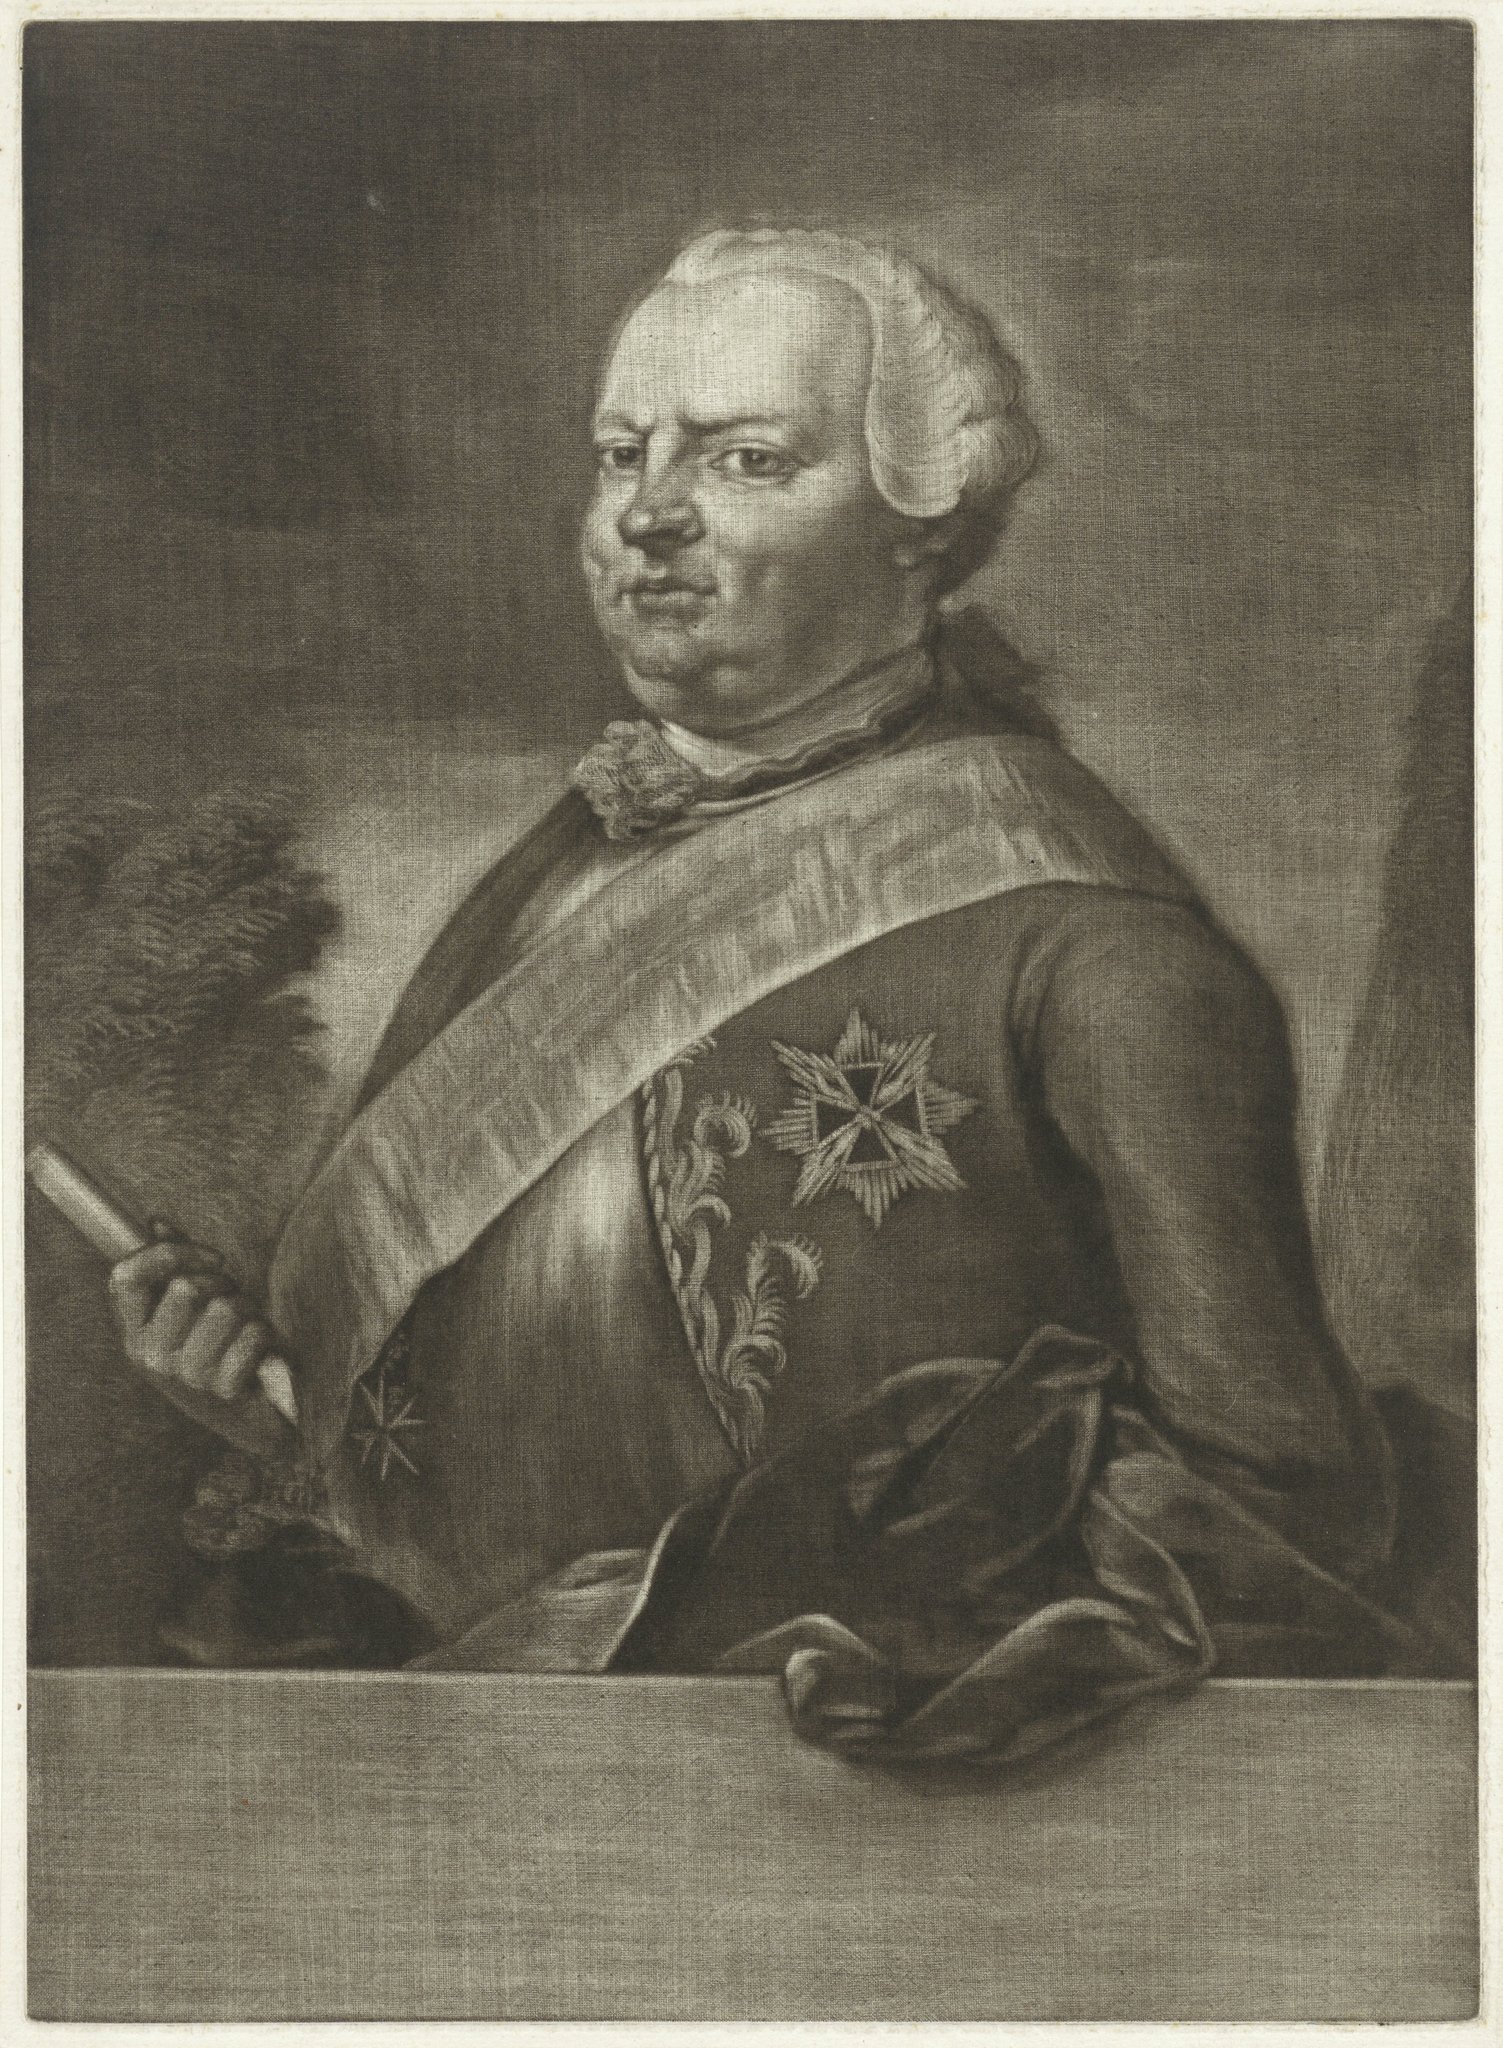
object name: print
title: Portret van Lodewijk Ernst, hertog van Brunswijk-Wolfenbüttel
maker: aert schouman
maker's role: draughtsman, painter, print maker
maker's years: 1710-1792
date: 1738-1792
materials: paper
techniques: mezzotint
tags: ludwig ernst von braunschweig-wolfenbüttel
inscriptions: collector's mark: Lugt 2228